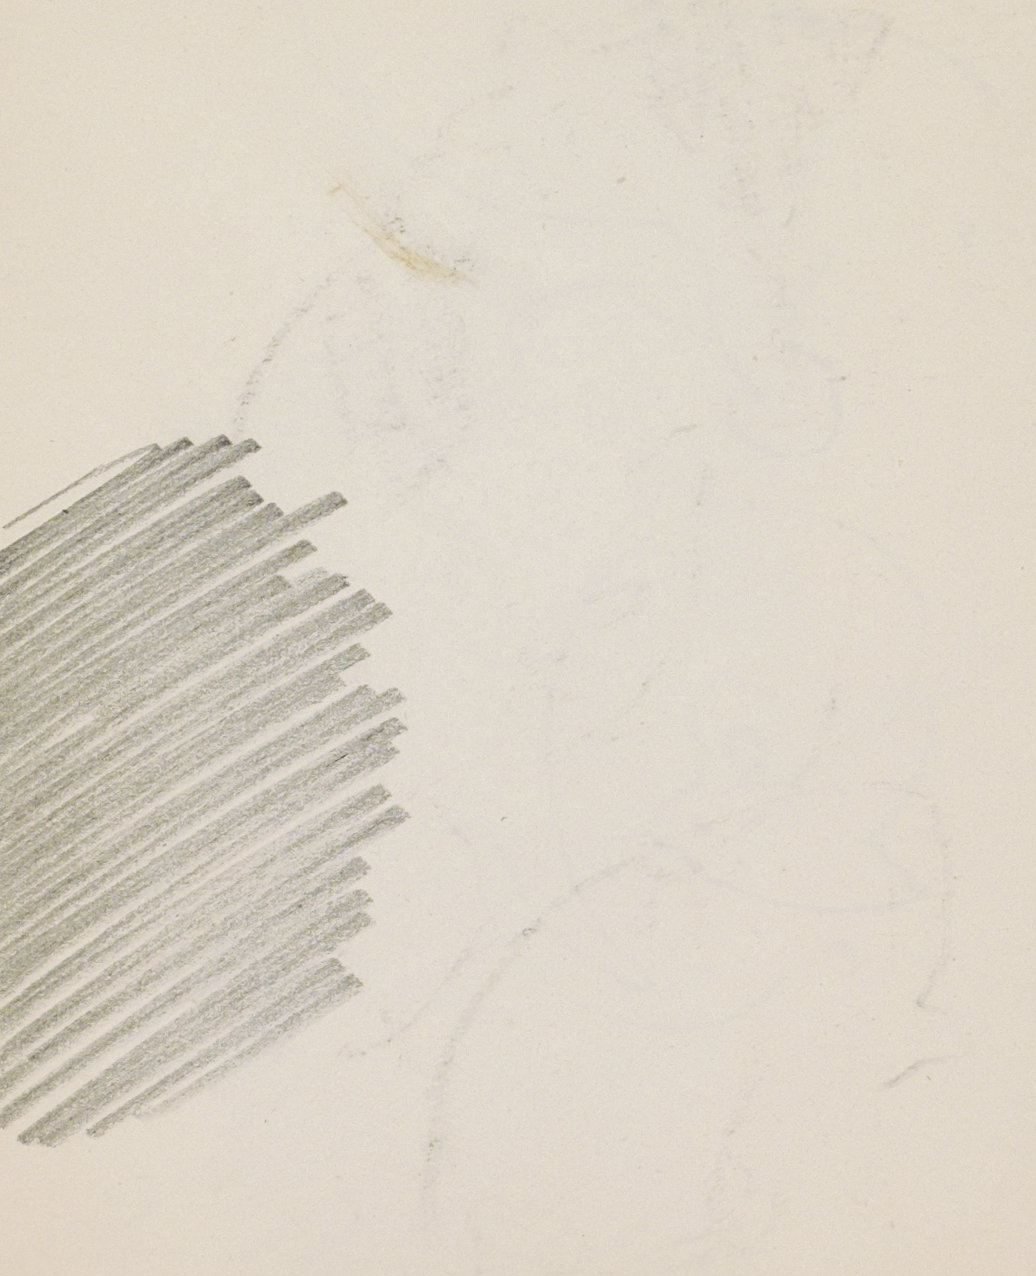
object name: sketchbook leaf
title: Studie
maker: reijer stolk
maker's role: draughtsman, print maker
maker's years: 1896-1945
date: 1906-1945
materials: paper, pencil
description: Blad 25 verso uit een schetsboek met 42 bladen.